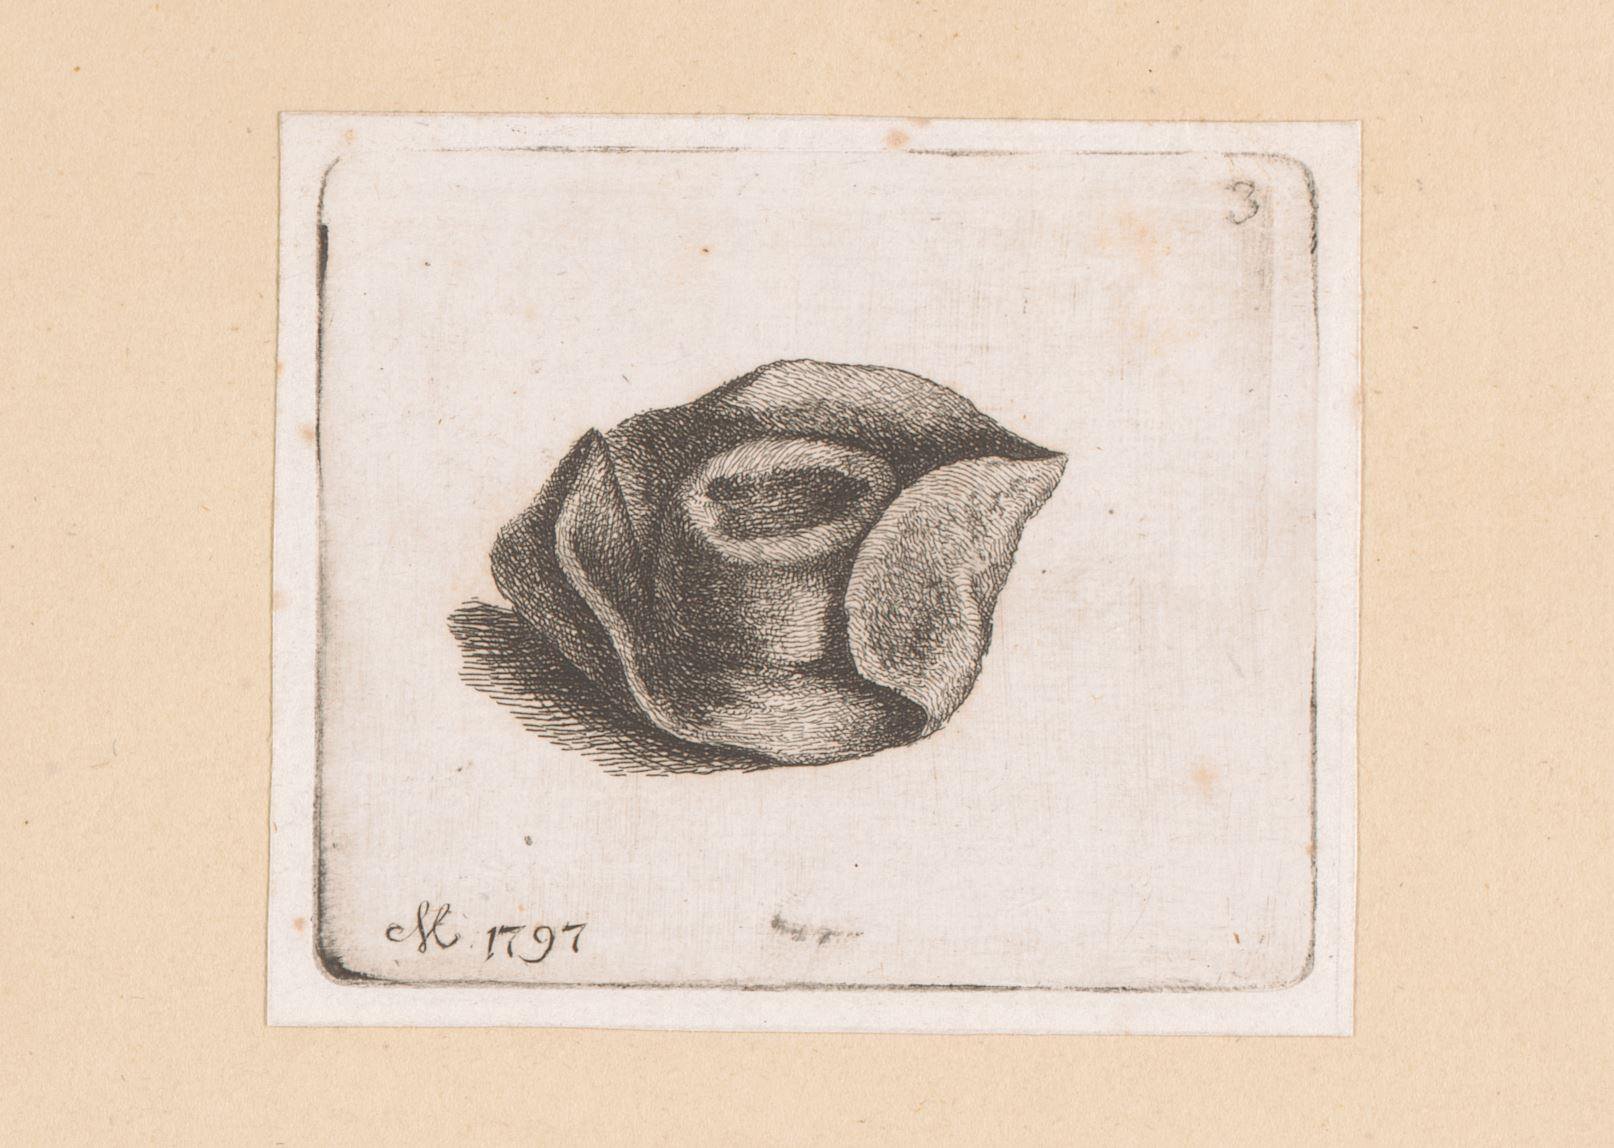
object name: print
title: Hoed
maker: johann friedrich morgenstern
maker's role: print maker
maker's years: 1777-1844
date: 1797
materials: paper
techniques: etching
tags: head-gear: hat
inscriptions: collector's mark: Lugt 2228